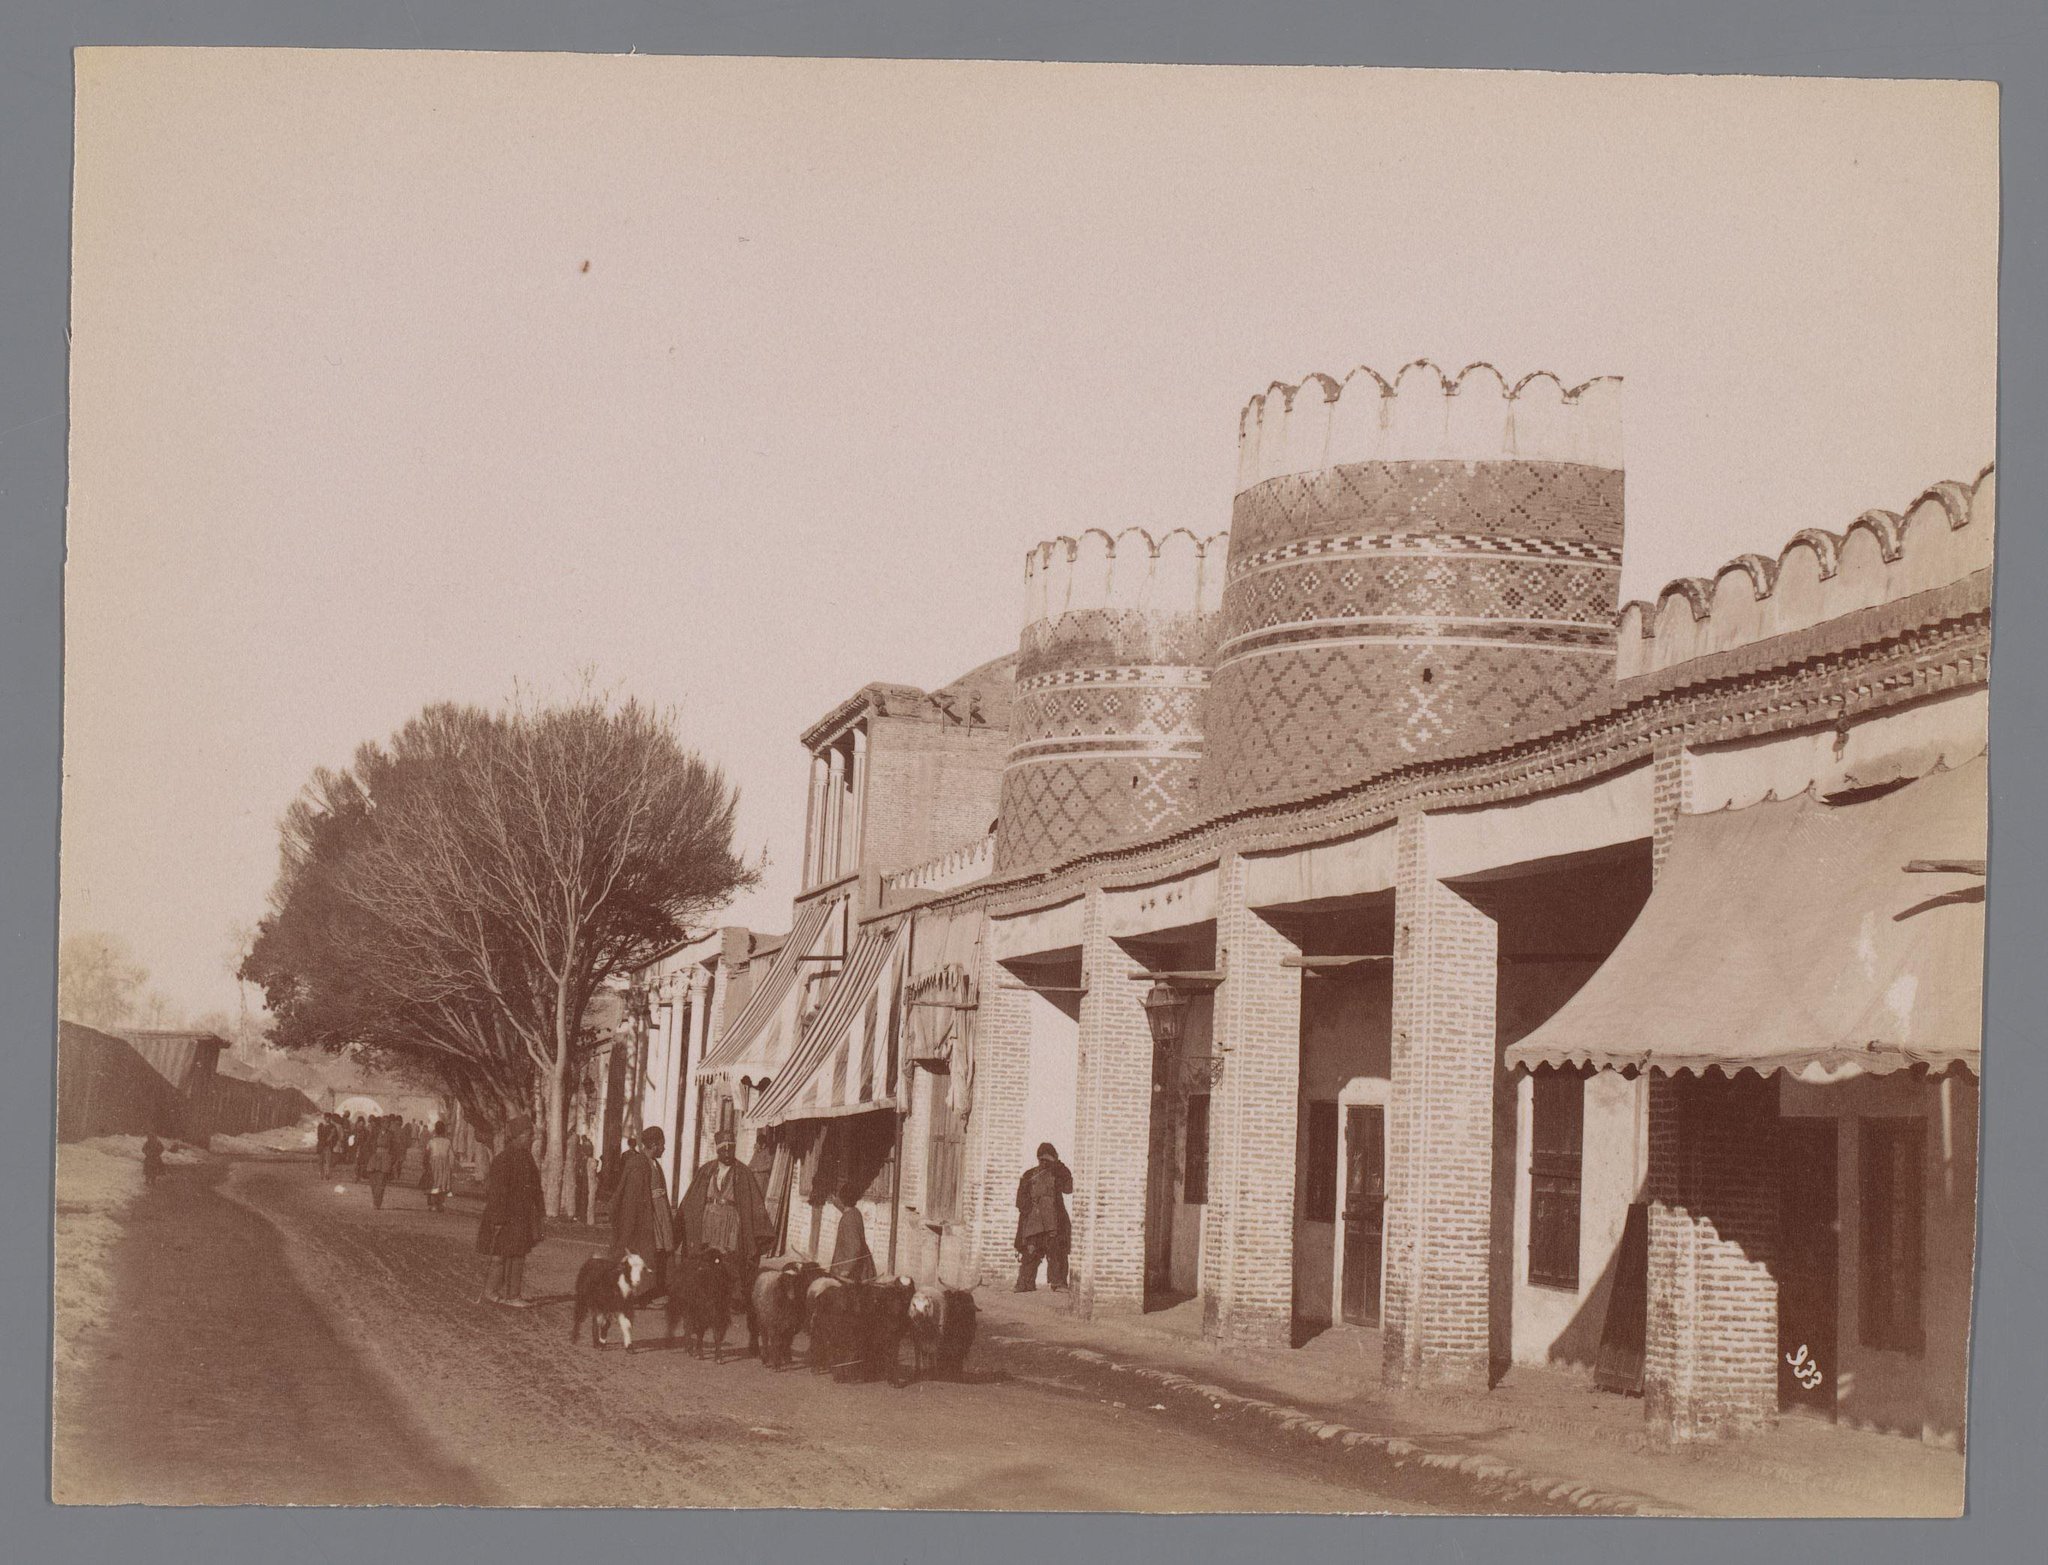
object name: photograph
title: Teheran Arc, Iran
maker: antoine sevruguin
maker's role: fotograaf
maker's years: 1840-1933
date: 1885-1910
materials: paper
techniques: albumen print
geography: iran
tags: teheran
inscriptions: inscription: ‘Teheran Arc’, number: ‘933’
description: Teheran Arc, Iran. Gebouw met twee ronde torens met kantelen langs een weg. Een groepje mannen met geiten staat voor het gebouw.